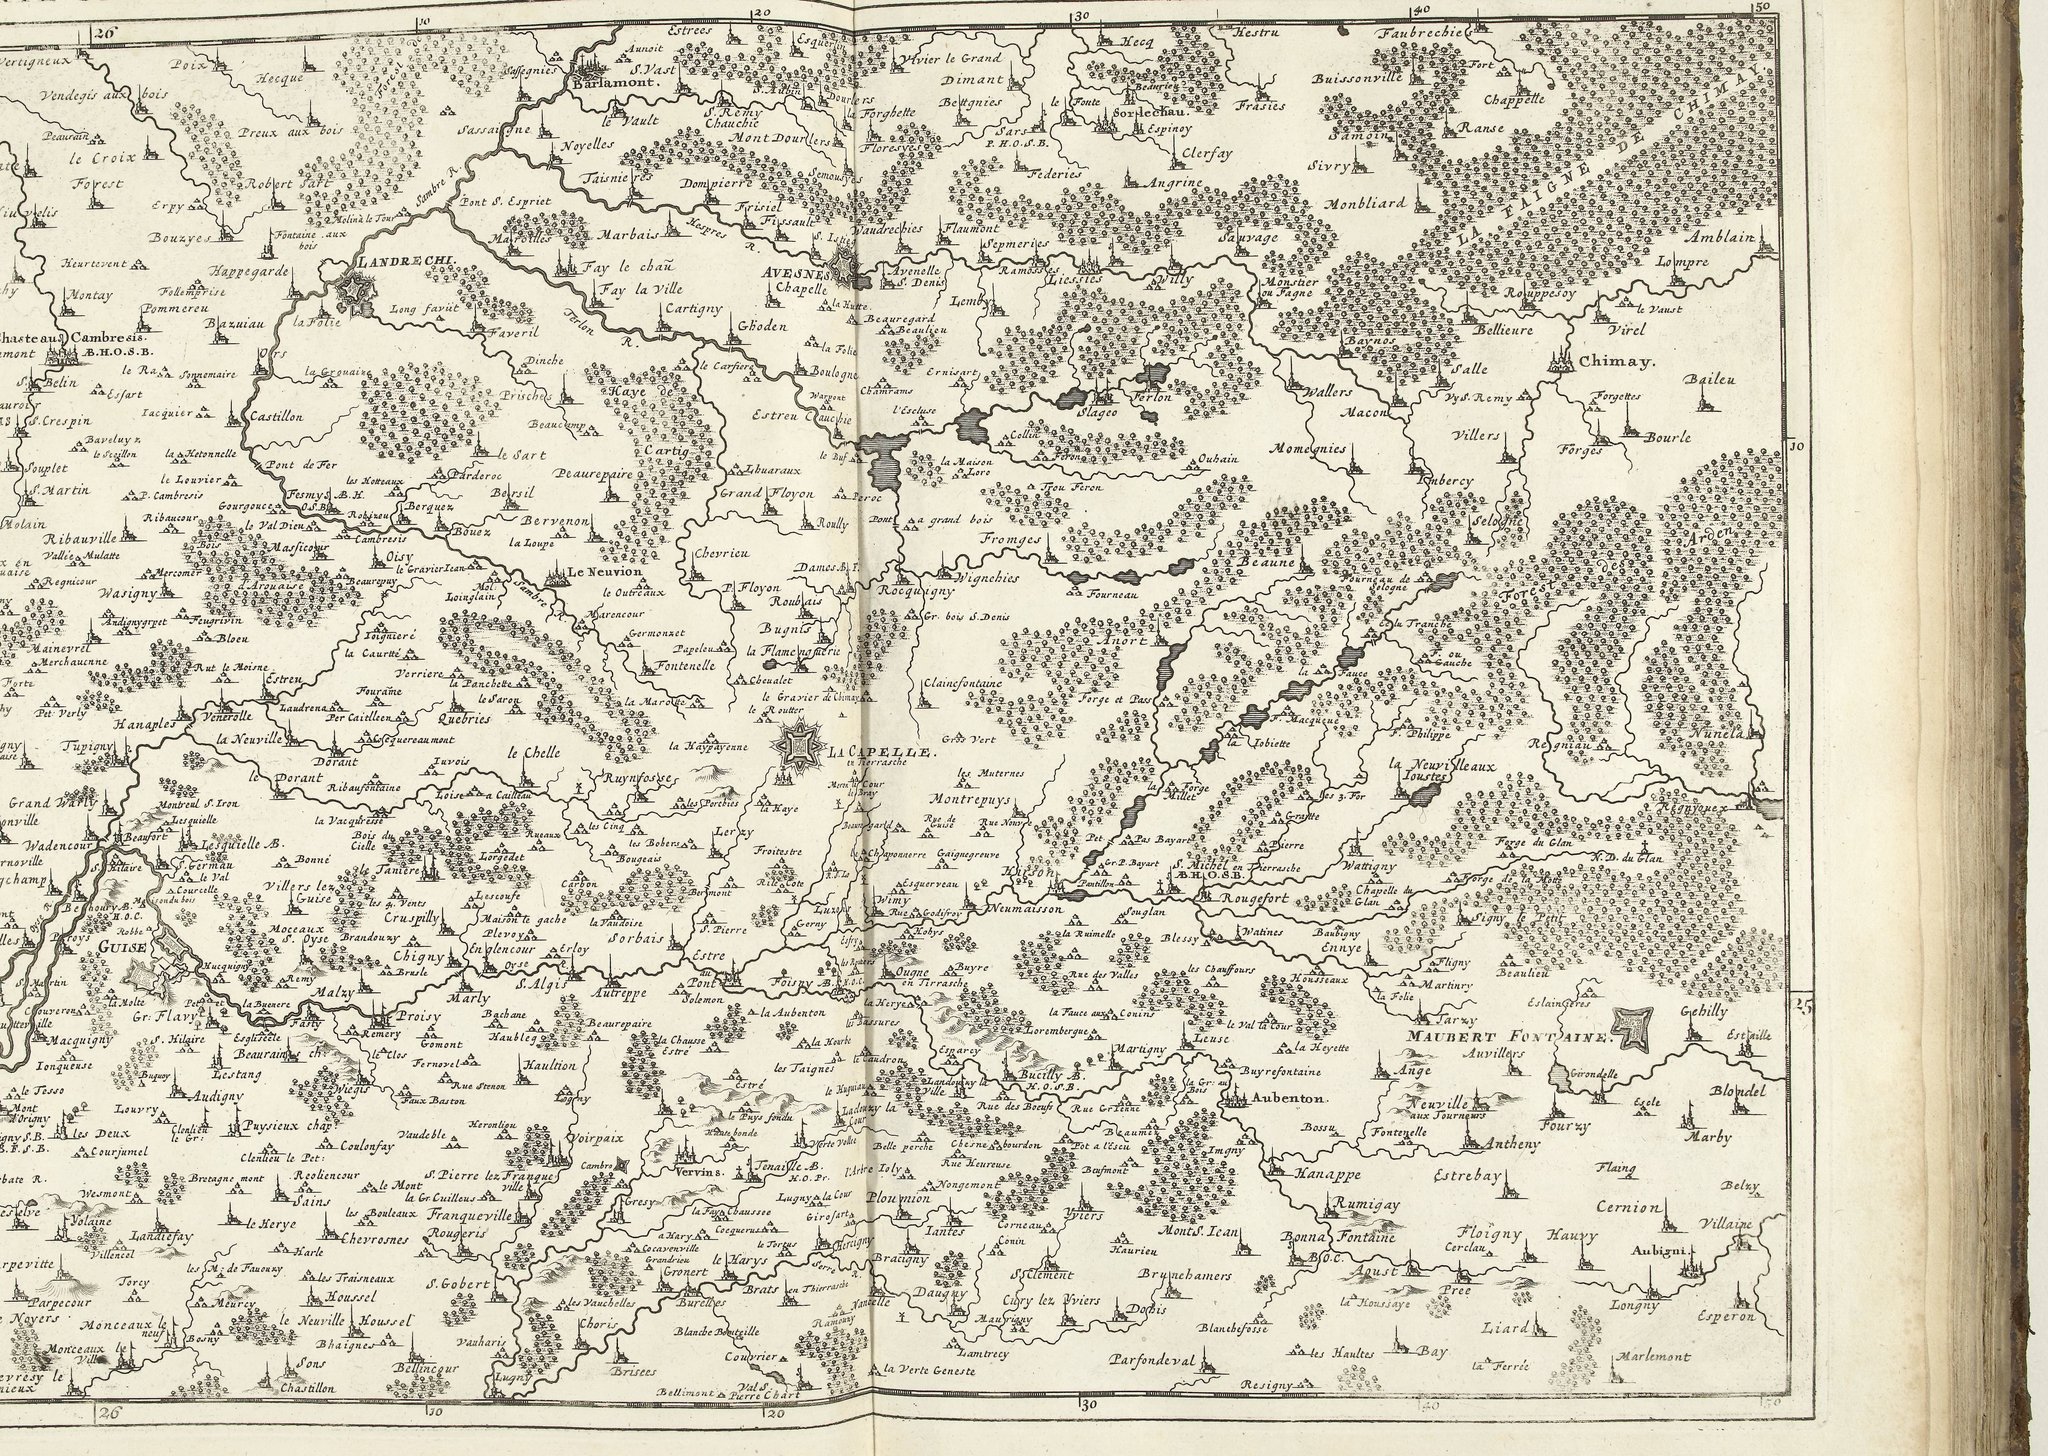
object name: print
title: Carte particuliere des environs d'Avesnes, Landrecy, la Capelle, Guise, etc.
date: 1712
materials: paper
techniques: engraving, etching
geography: brussels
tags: maps of separate countries or regions, northern france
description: Kaart van Noord-Frankrijk met de steden Avesnes, Landrecies, la Capelle en Guise, 1712. Onderdeel van een gebundelde verzameling van plannen van veldslagen en steden vermaard in de Spaanse Successieoorlog. Deze plaat behoort tot de eerste 24 platen die samen een zeer grote kaart van de Zuidelijke Nederlanden vormen.